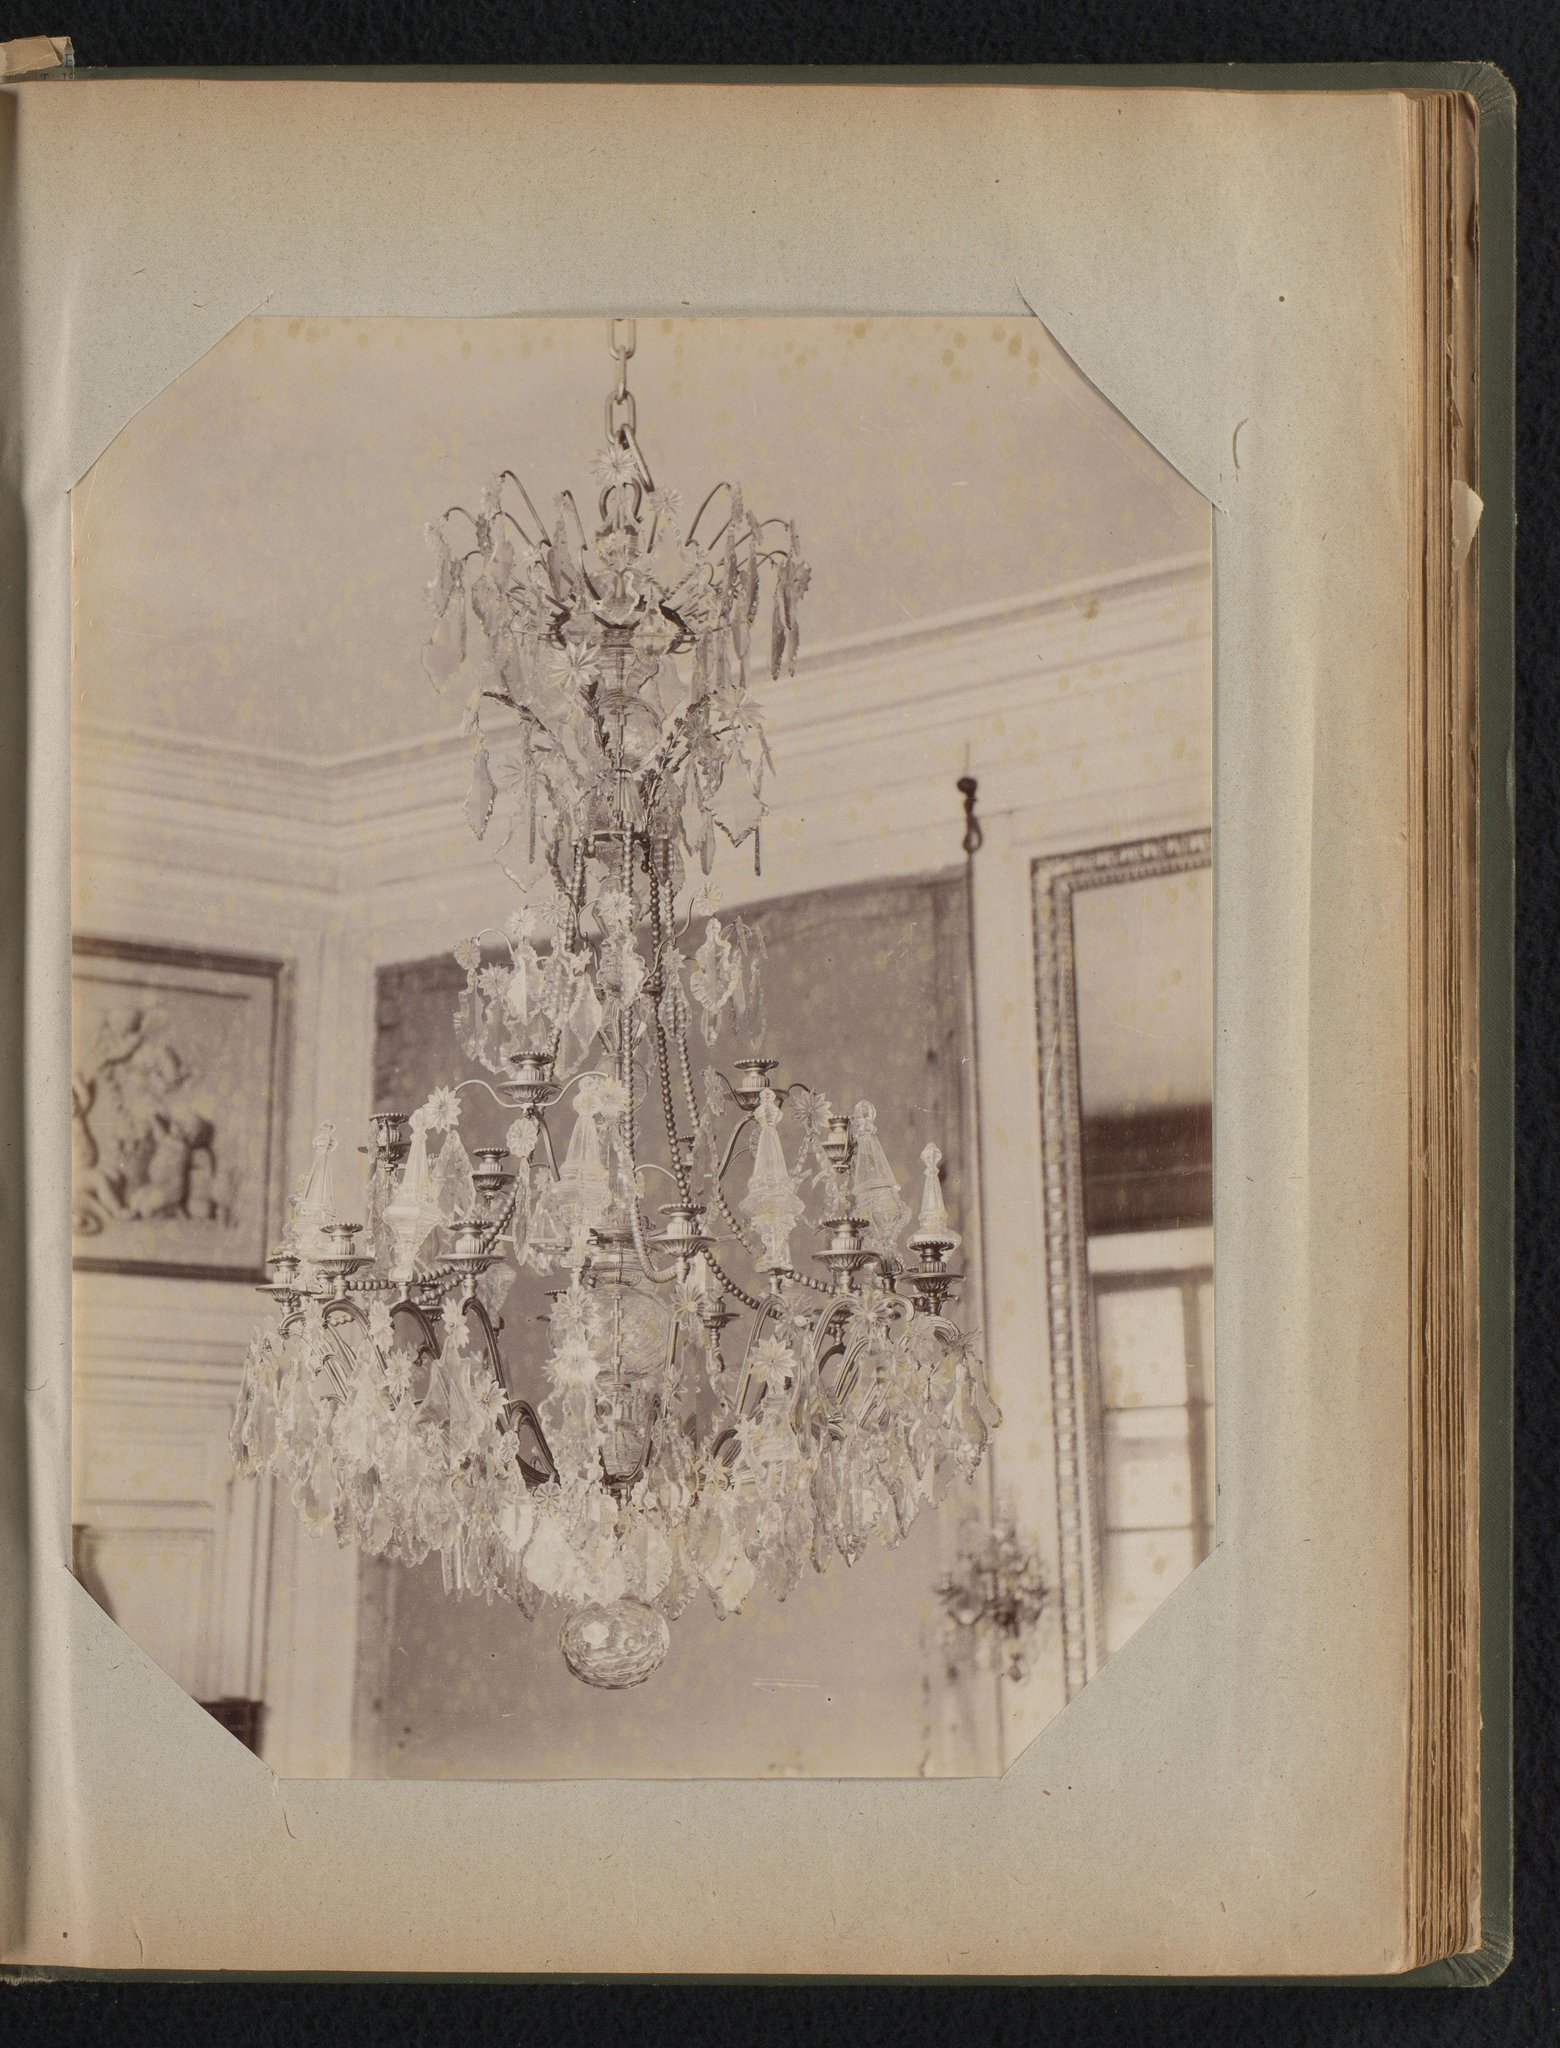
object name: photograph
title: Vergulde bronzen kroonluchter met kristallen decoratie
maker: Anonymous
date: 1860-1900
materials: canvas, cardboard, paper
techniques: albumen print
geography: netherlands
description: Onderdeel van een serie met betrekking tot het interieur van het paleis van Versailles met kroonluchters, deuren, portalen en meubelstukken.